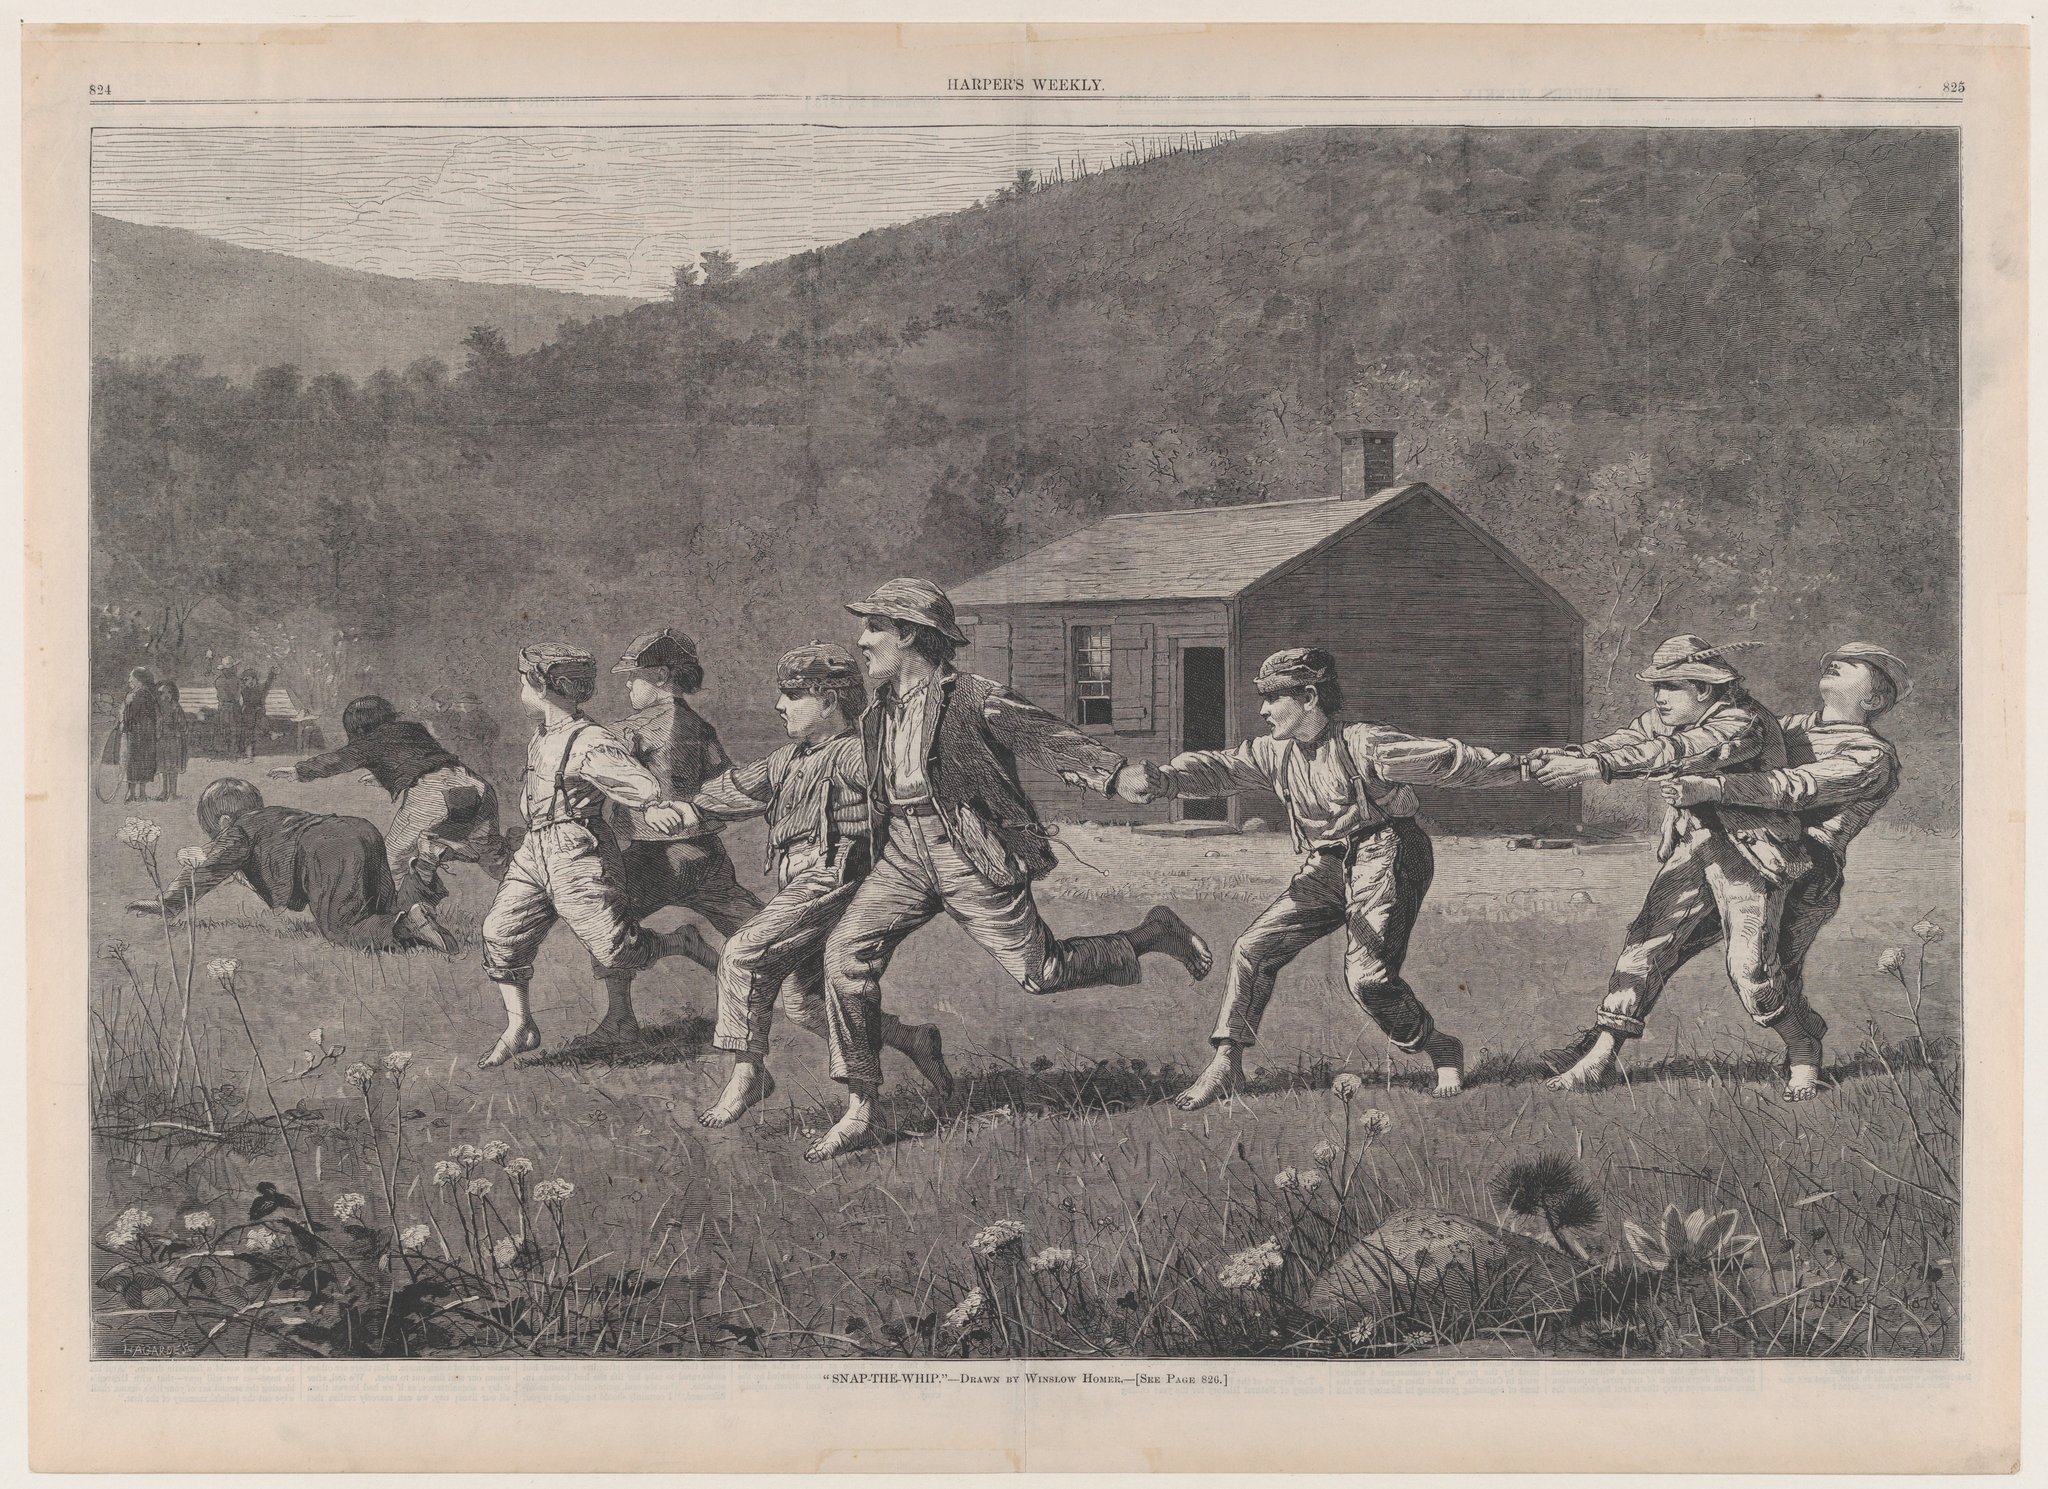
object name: print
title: Snap-the-Whip (from "Harper's Weekly," Vol. XVII)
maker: winslow homer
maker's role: artist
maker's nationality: american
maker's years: 1836-1910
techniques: engraving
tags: houses,boys,running,flowers,plants